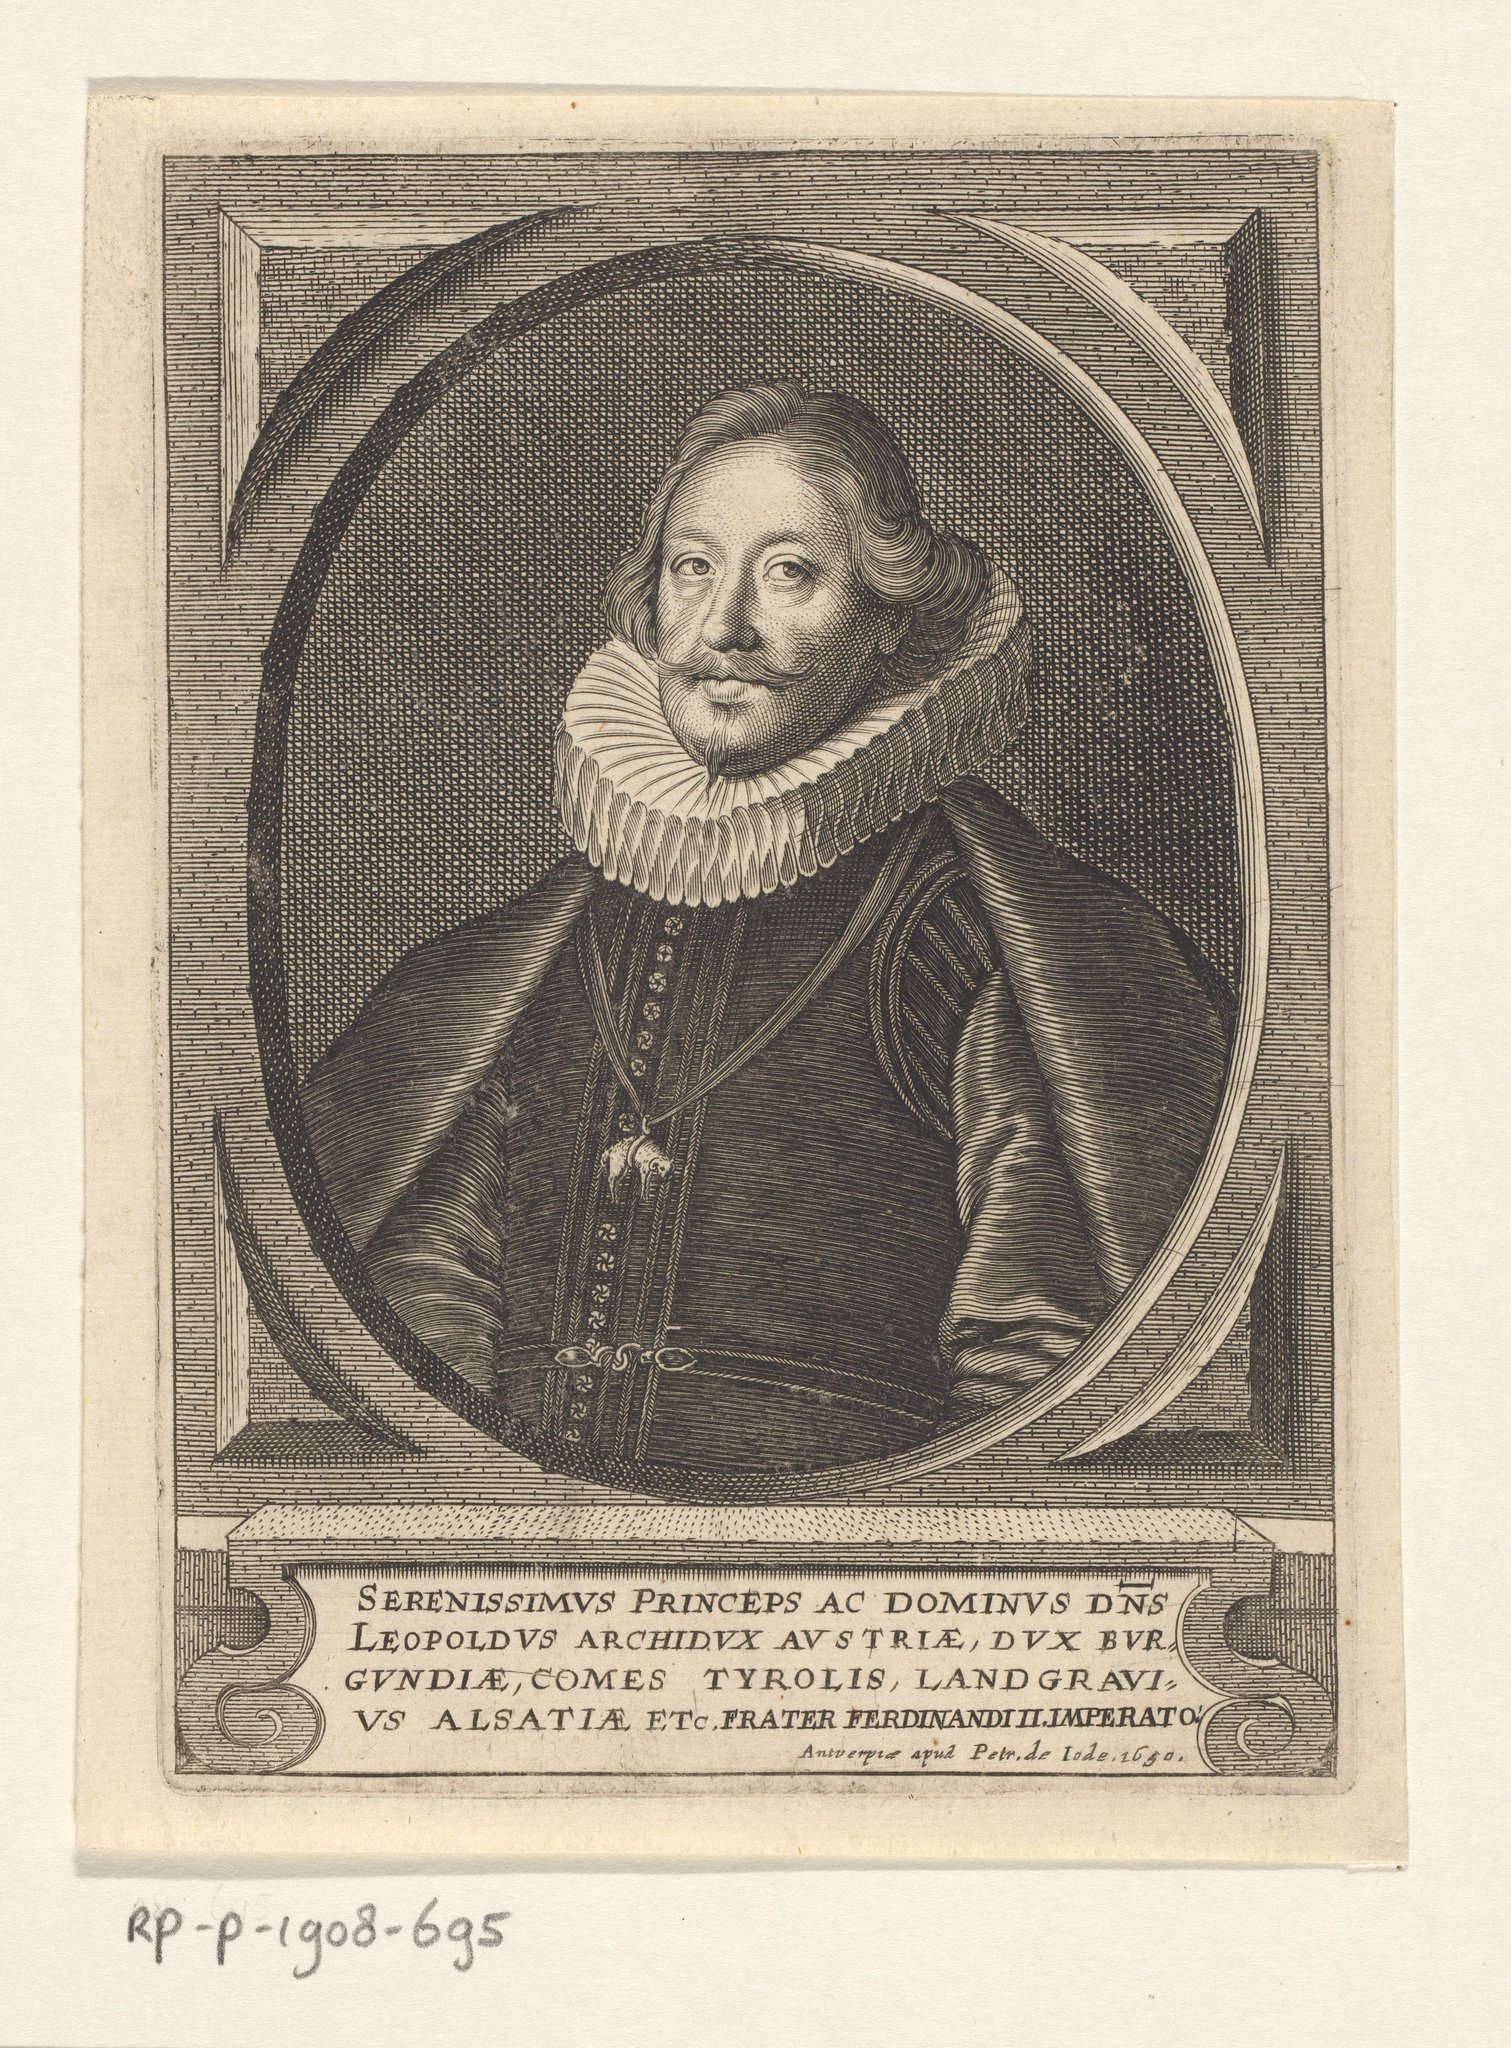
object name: print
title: Serenissimus Princeps ac Dominus DNS Leopoldus Archidux Austriae (...)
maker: pieter de jode (ii)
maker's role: draughtsman, print maker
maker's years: 1606-1674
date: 1650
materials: paper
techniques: engraving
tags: leopold v (aartshertog van oostenrijk), historical persons, knighthood order of the golden fleece, ruler, sovereign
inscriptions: collector's mark: Lugt 2228